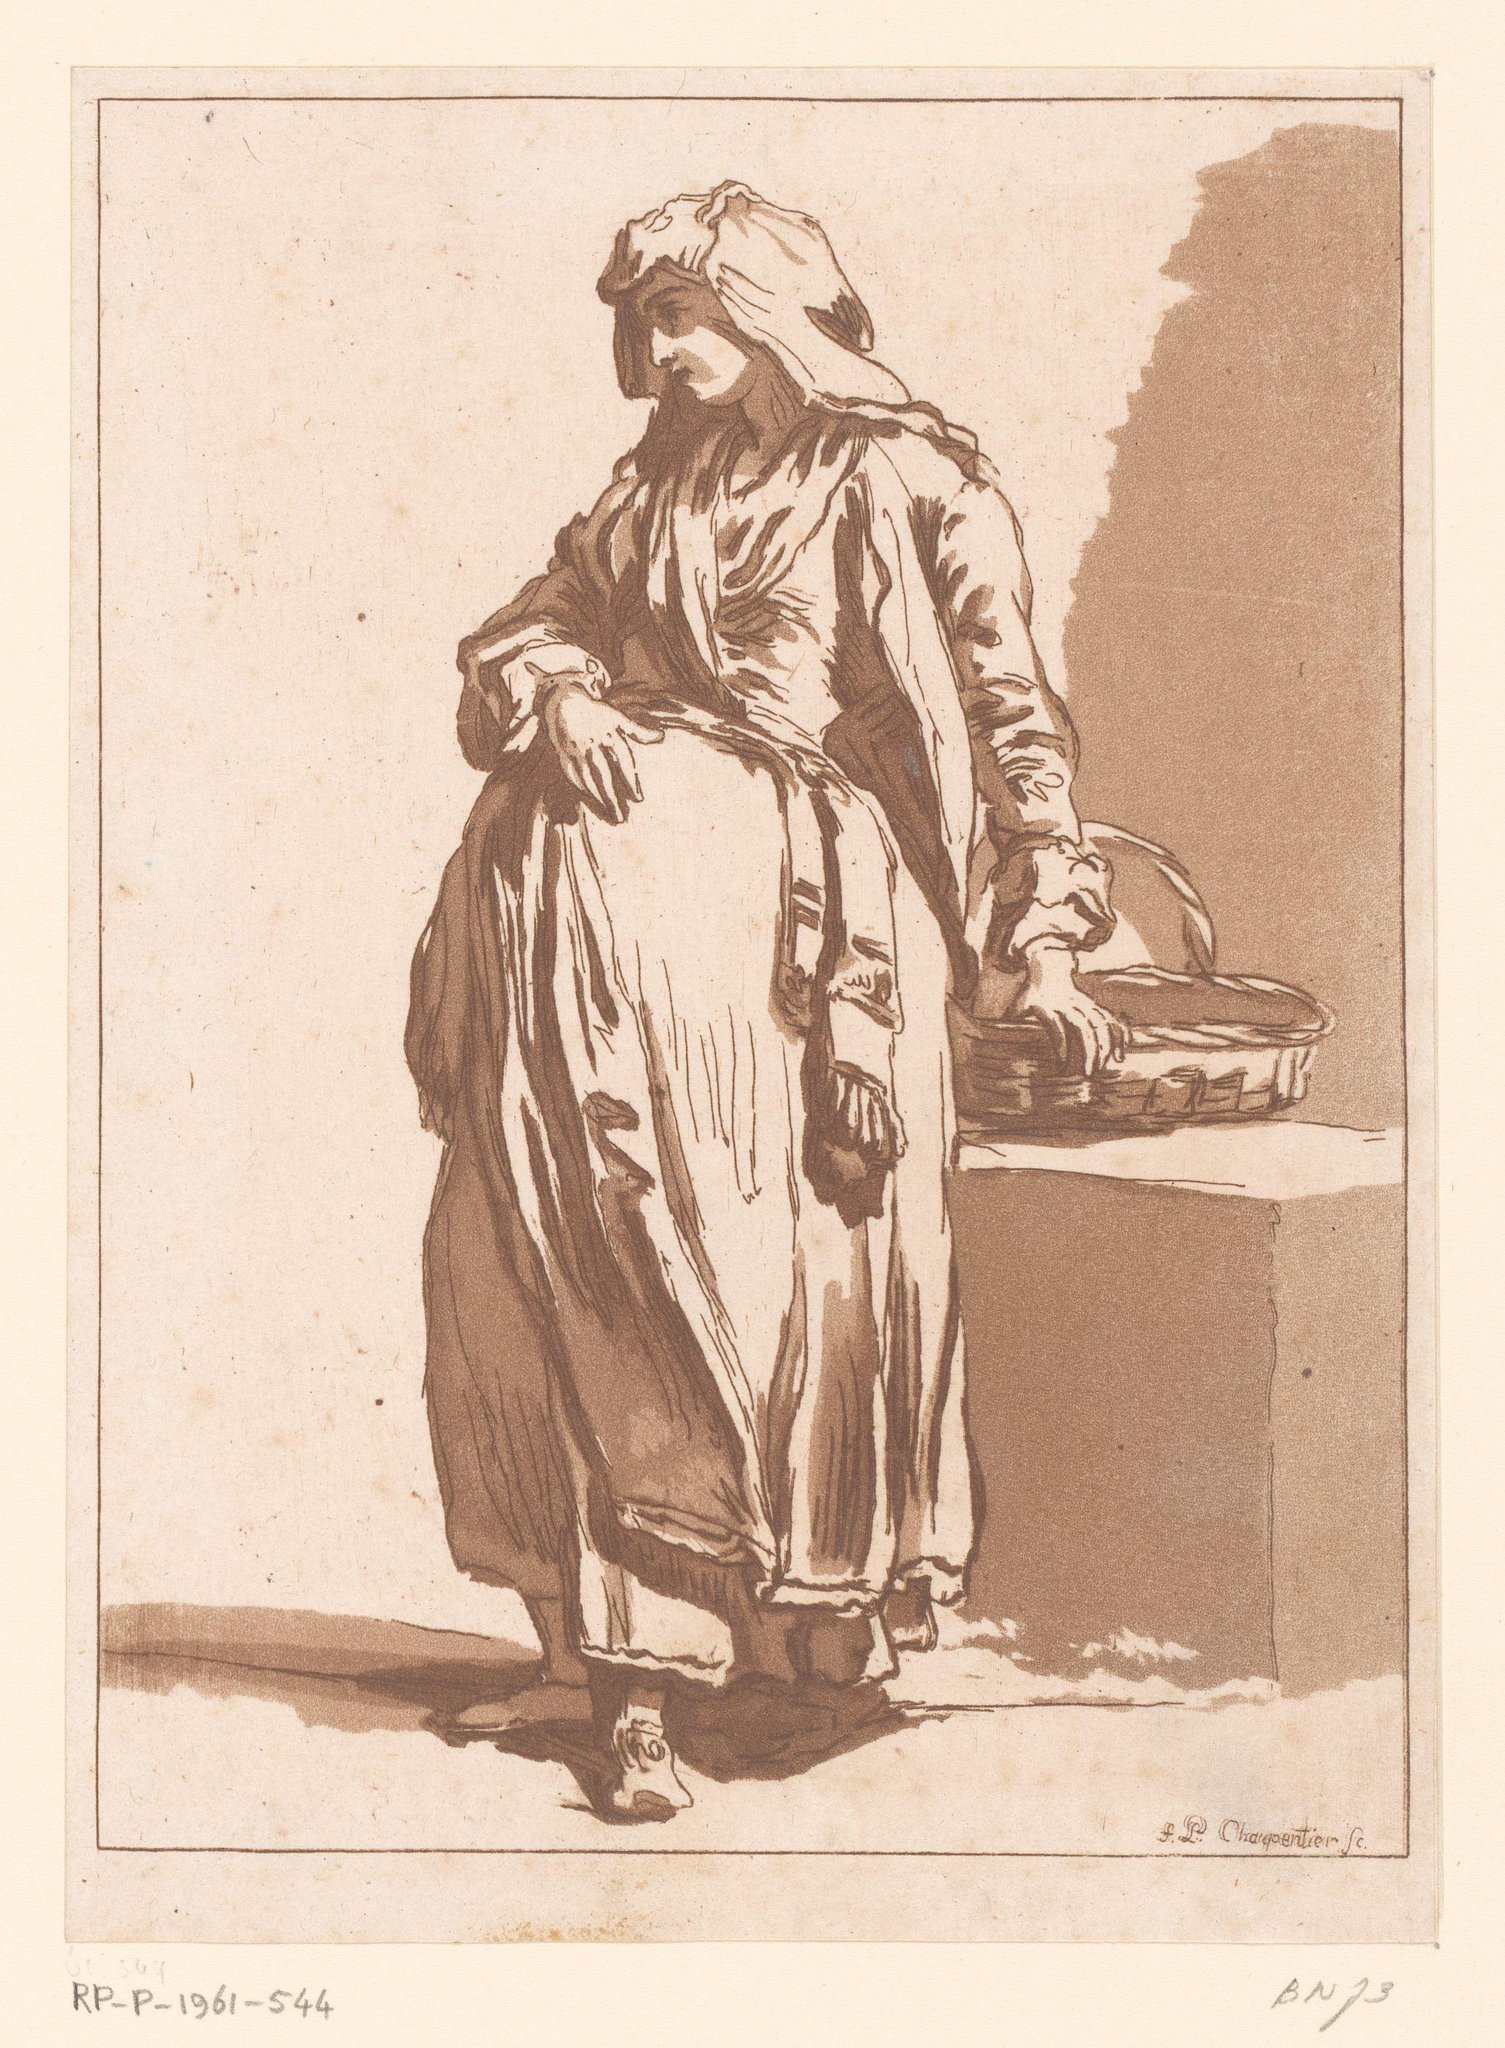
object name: print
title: Boerenvrouw met een mand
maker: françois philippe charpentier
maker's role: print maker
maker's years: 1734-1817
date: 1744-1817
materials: paper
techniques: aquatint, etching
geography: france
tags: adult woman, container made of plant material other than wood: basket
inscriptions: collector's mark: ‘"School voor de grafische vakken te Utrecht"’, collector's mark: Lugt 2228